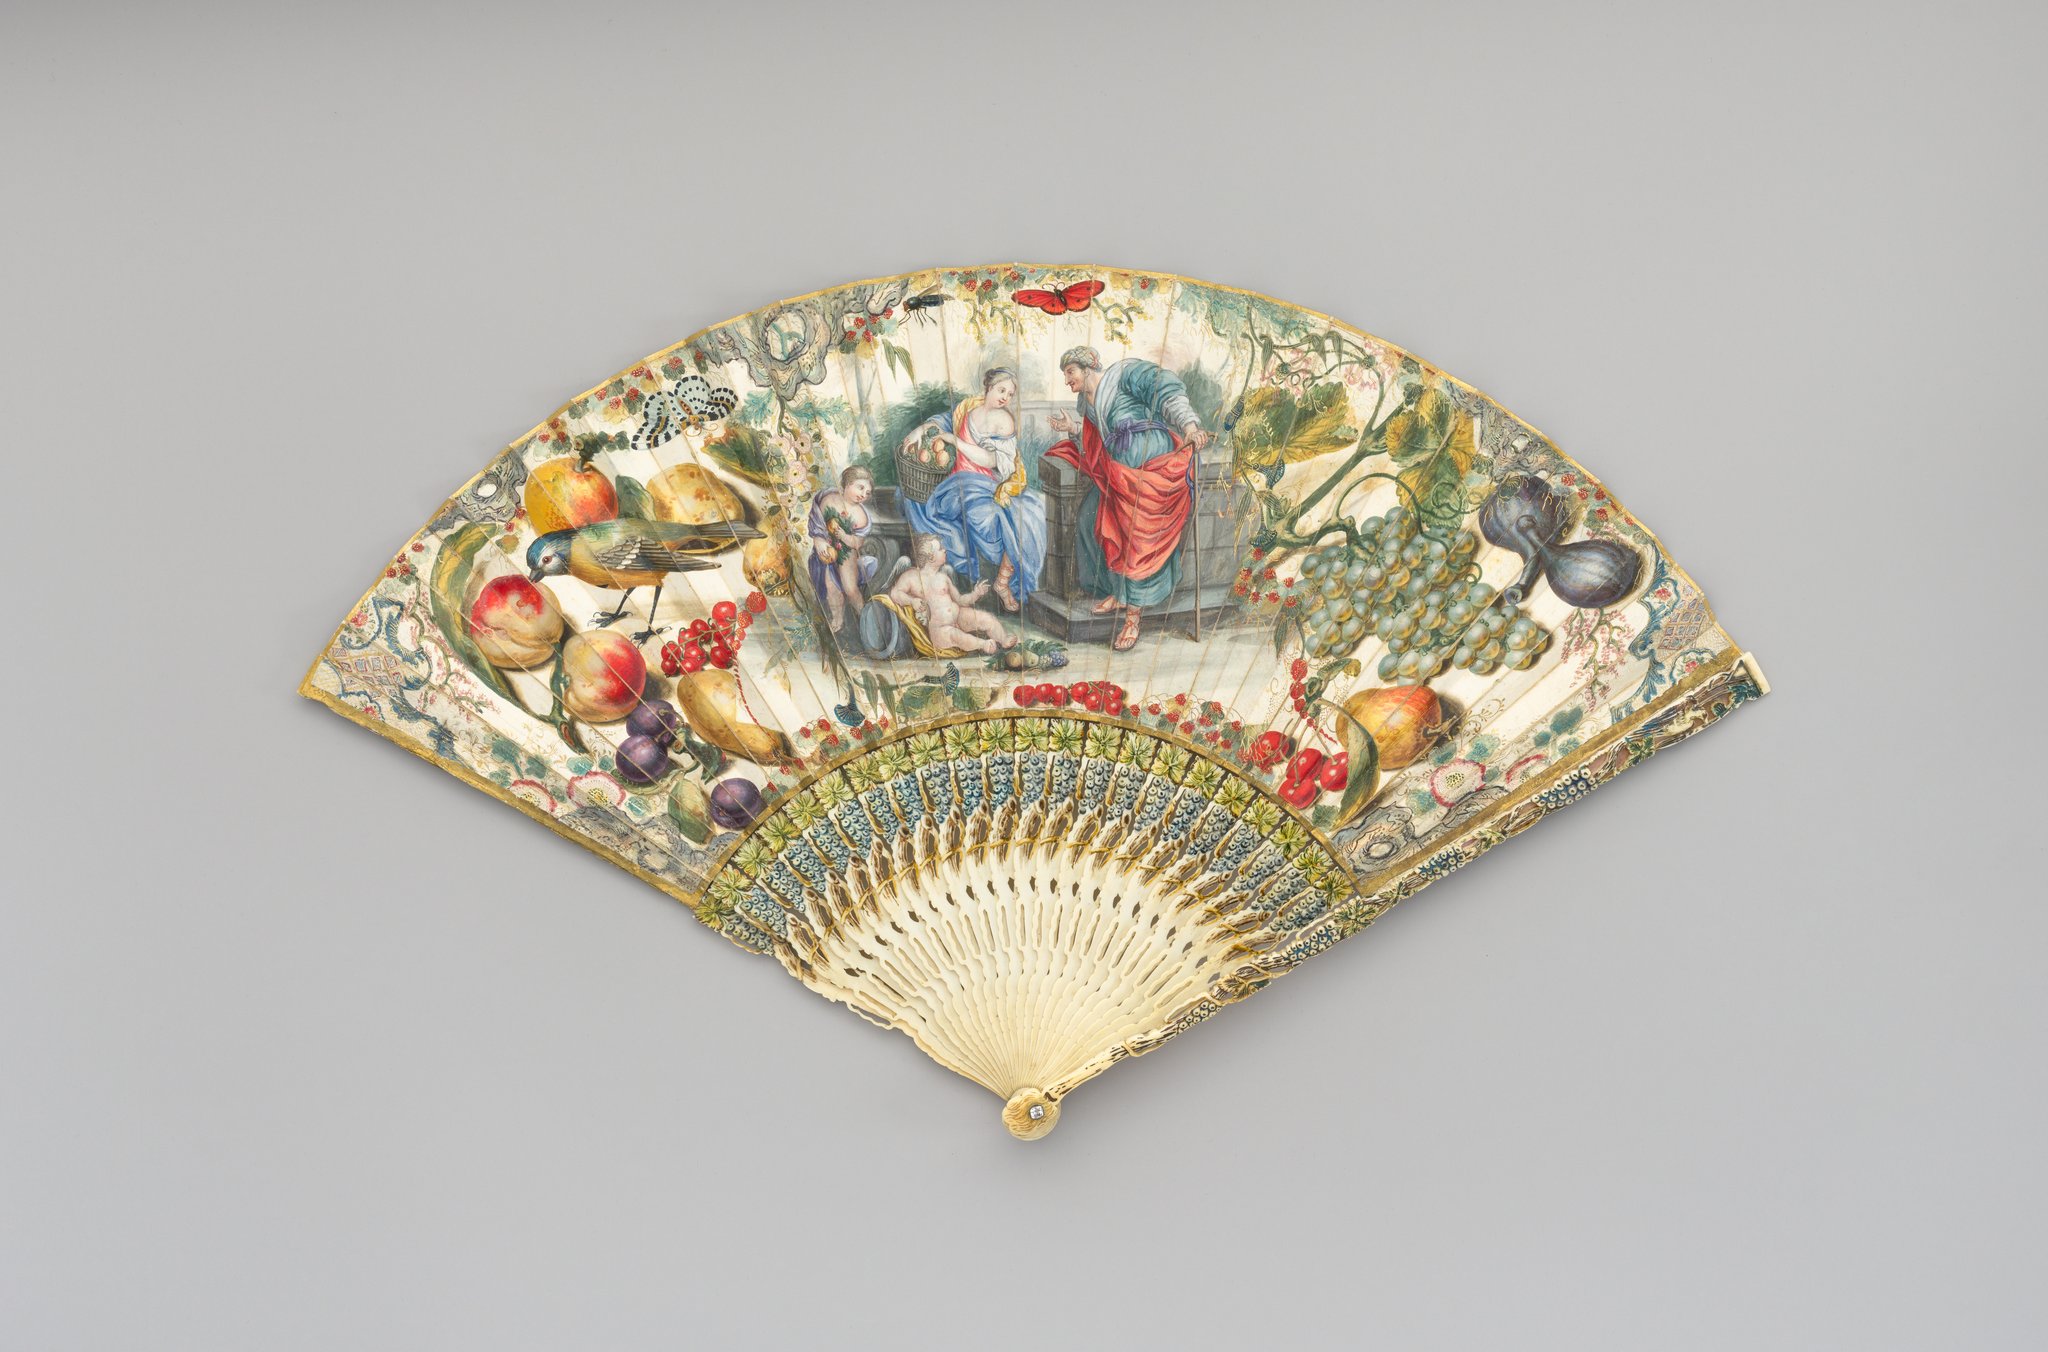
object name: fan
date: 1701-1800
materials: ivory, paper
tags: birds,fruit,men,women